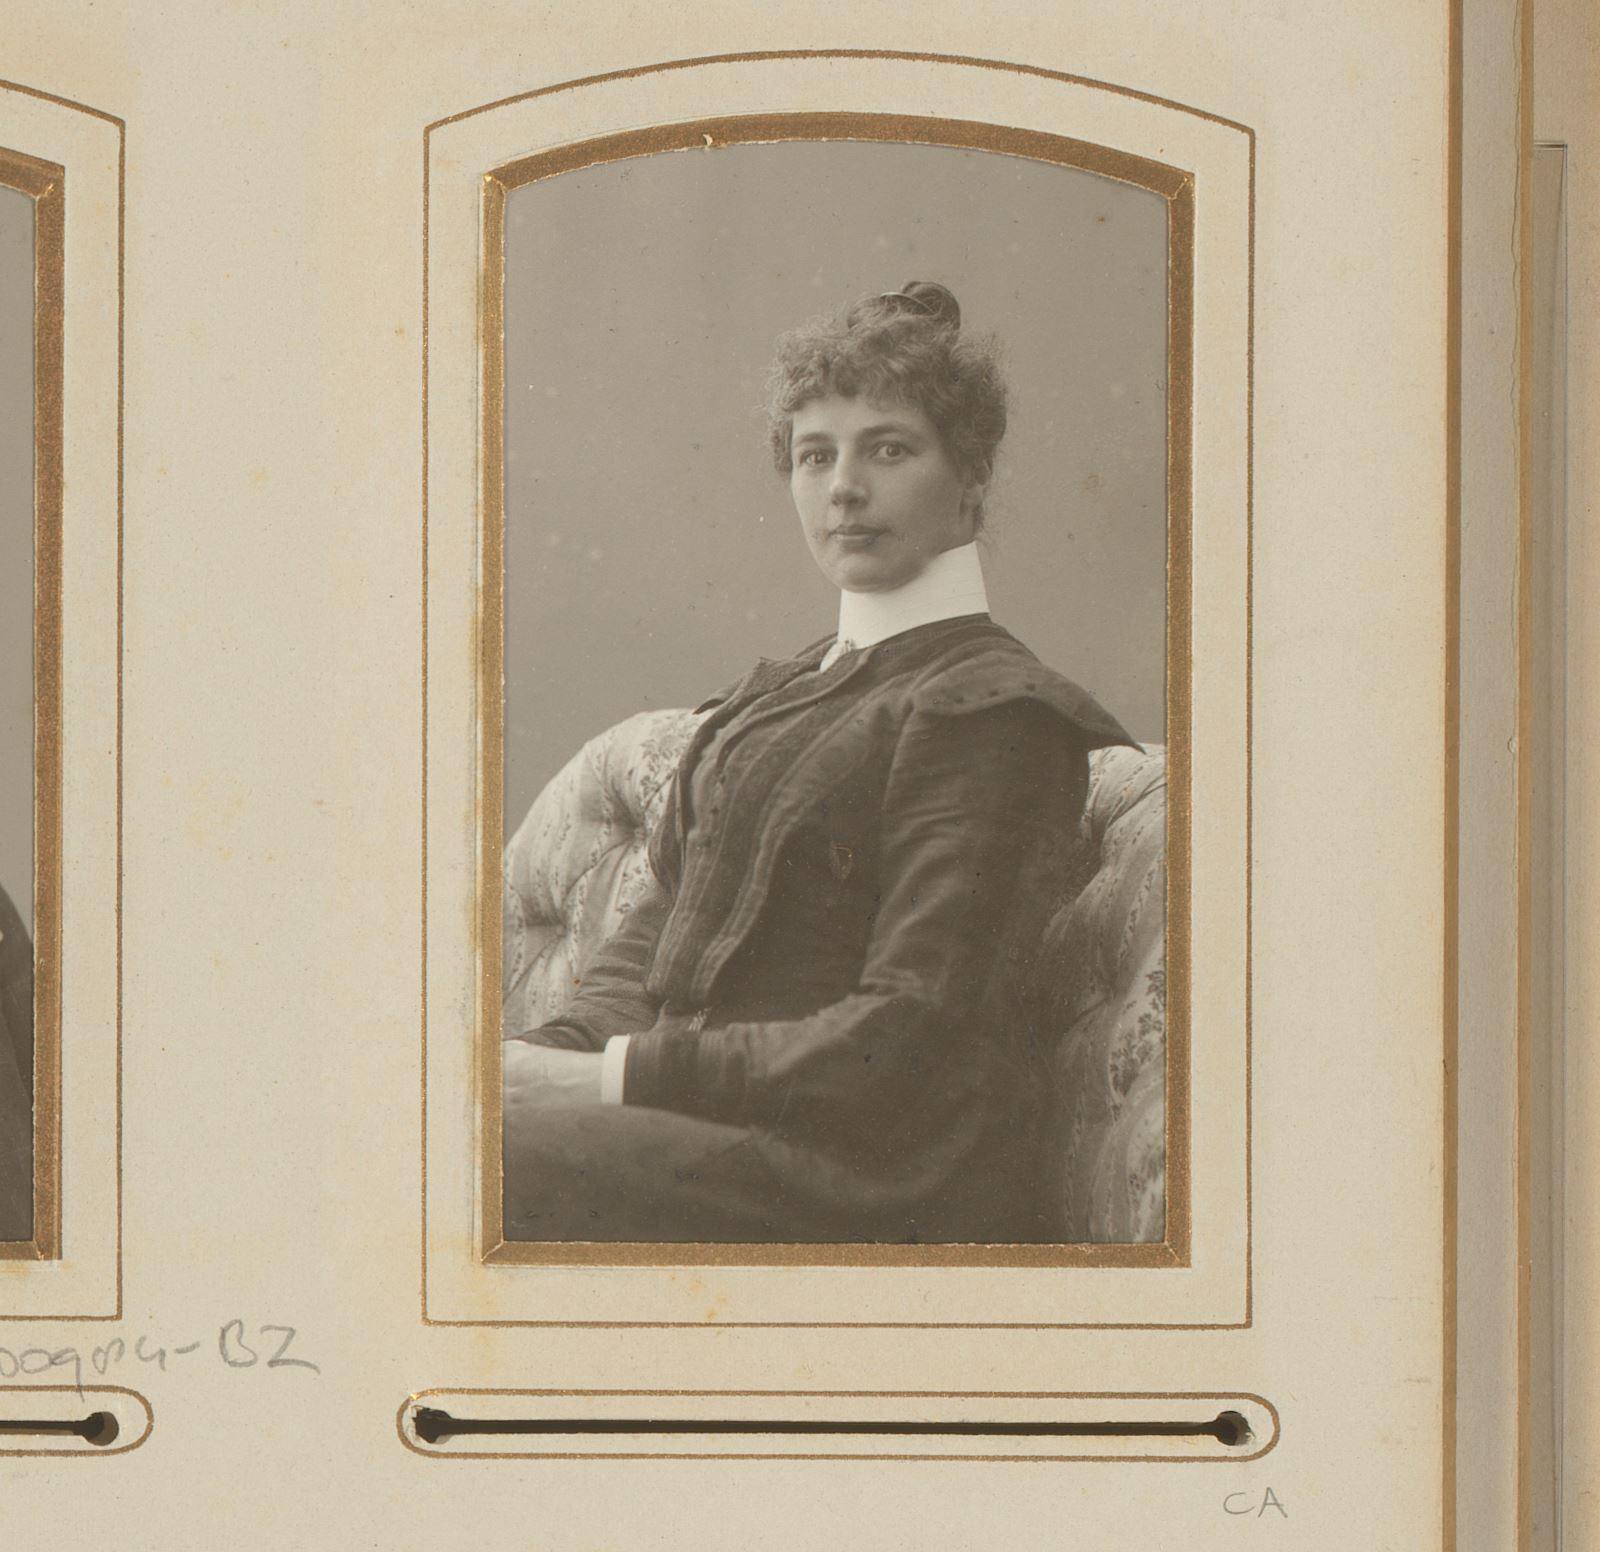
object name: photograph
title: Portret van een zittende vrouw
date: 1905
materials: cardboard, photographic support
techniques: collodion silver print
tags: sitting figure - aa - female human figure, historical persons - bb - woman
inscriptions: date: ‘1905’, inscription: ‘J.C. Reesinck/ Zutphen - Deventer/ Het cliché blijft voor nabestelling bewaard./ Speciale inrichting/ voor het vergrooten/ in onveranderlijke Kooldruk/ en Platina.’